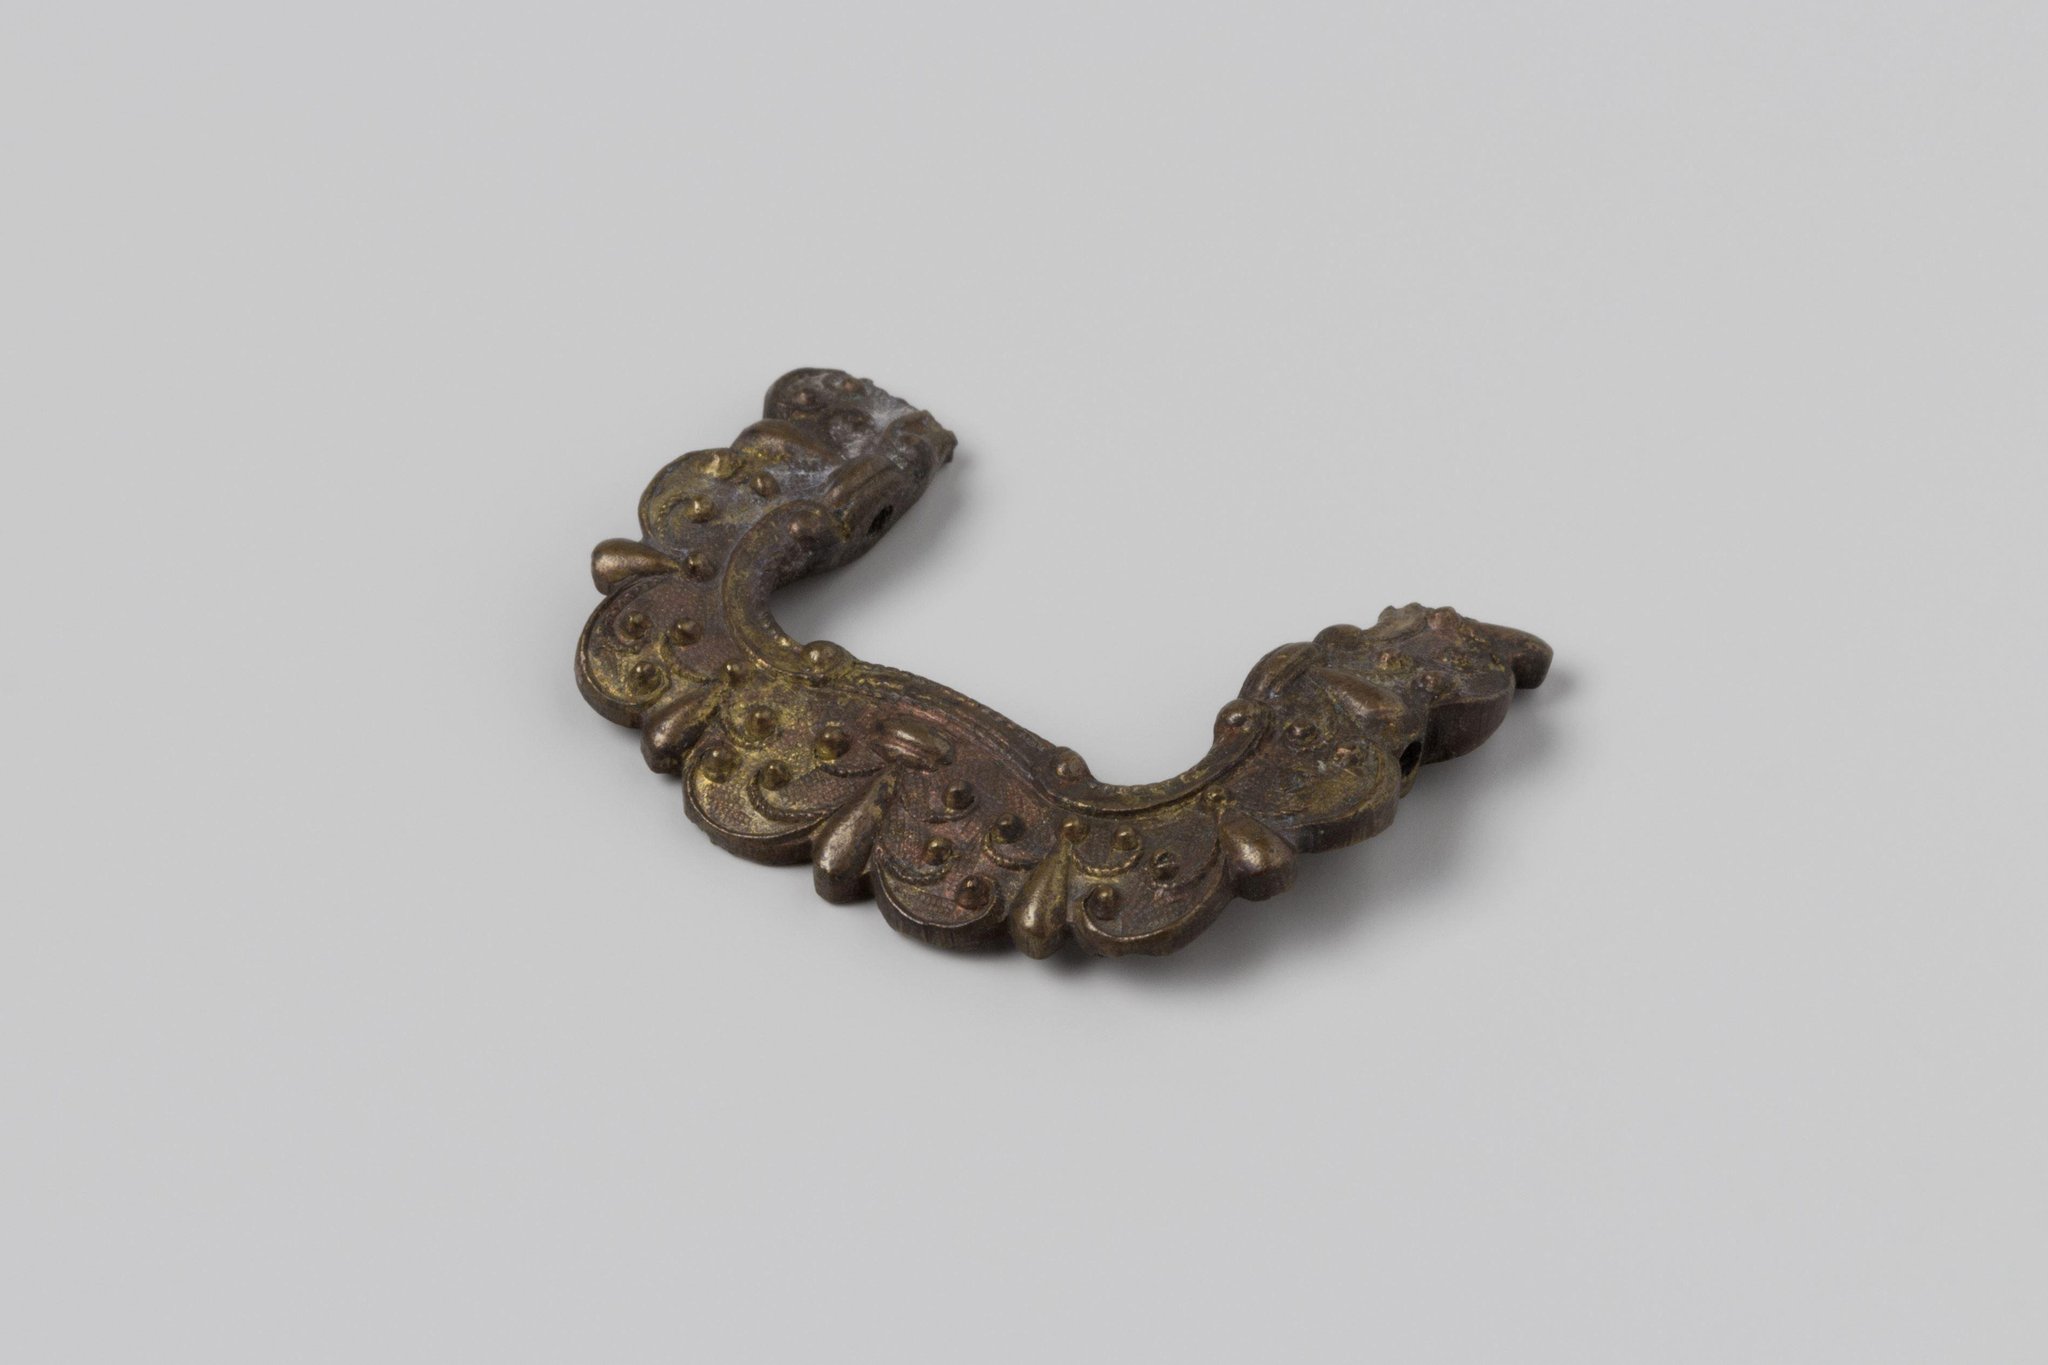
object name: knee buckle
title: Kniegesp uit het wrak van de Oost-Indiëvaarder Hollandia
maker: Anonymous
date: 1700-1743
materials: copper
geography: netherlands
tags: verenigde oostindische compagnie, hollandia (schip), annet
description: Kniegesp. Buckle, chape buckle, knee buckle; (1) fragment of ring (3.51, 0.2t), wavy outer rim, relieved decoration of raised dots and drops (spindle longitudinal).